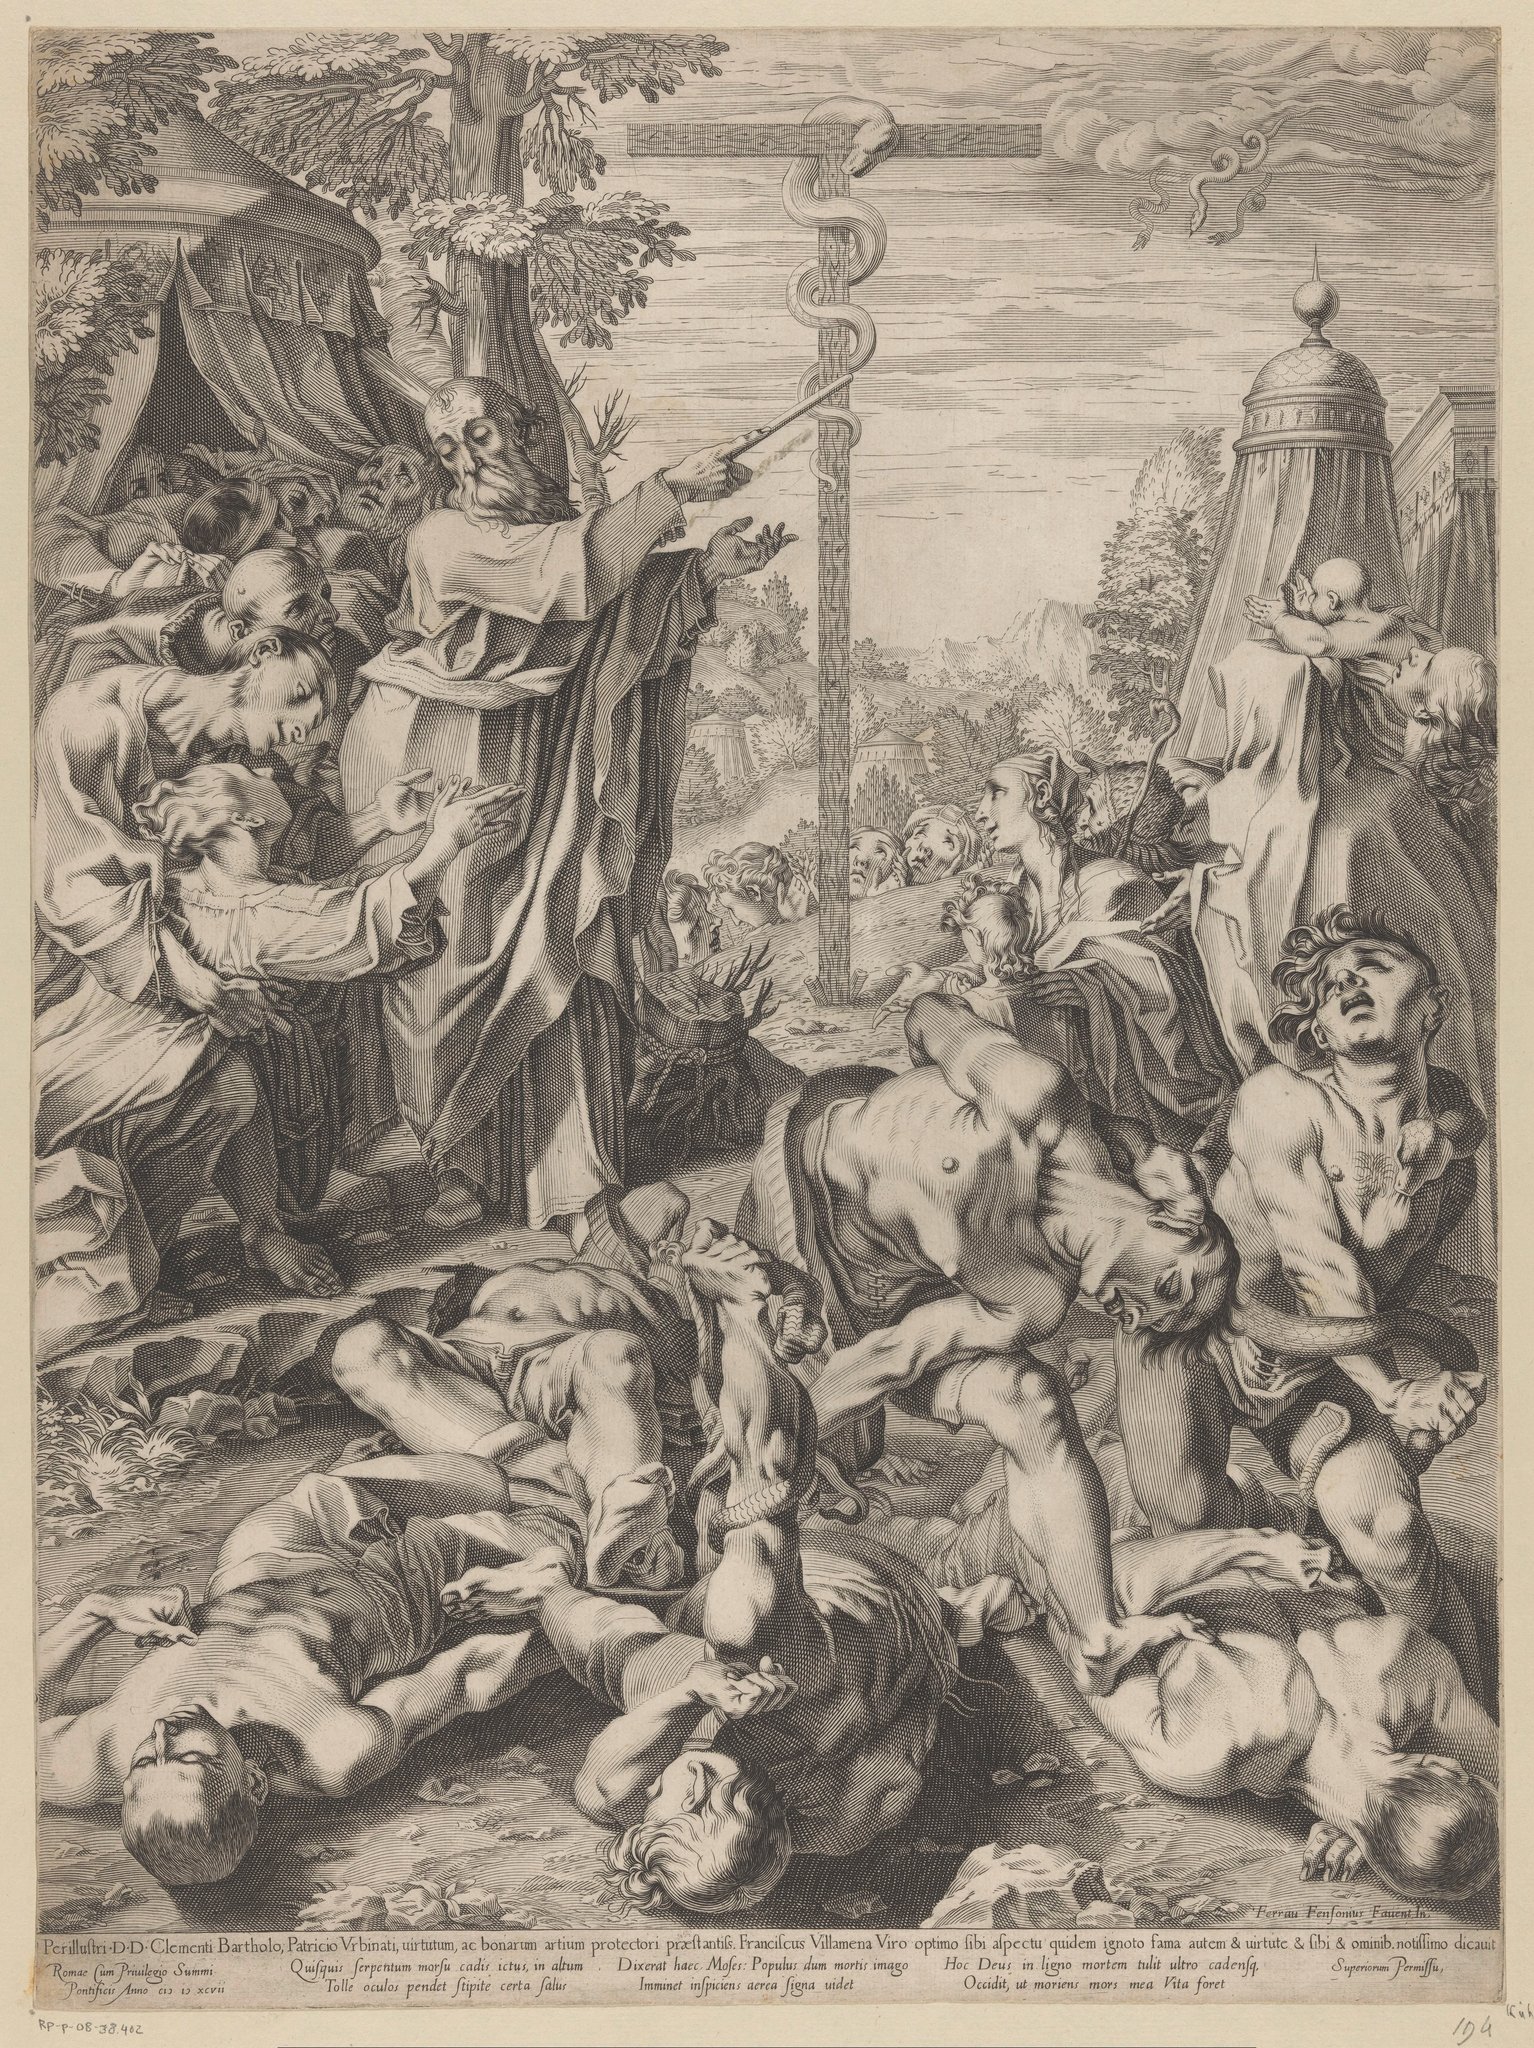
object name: print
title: Mozes en de koperen slang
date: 1597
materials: paper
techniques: engraving, etching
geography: italy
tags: the brazen serpent (numbers 21:4-9)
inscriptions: collector's mark: Lugt 240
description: In het midden de koperen slang bevestigd op een tau-vormige paal. Links daarvan staat Mozes. Op de voorgrond de Israëlieten kronkelend op de grond met slangen rondom hun ledematen. Sommigen kijken op naar de koperen slang om in leven te blijven. Op de achtergrond het tentenkamp van de Israëlieten. Opdracht en Latijnse tekst in drie kolommen in ondermarge.